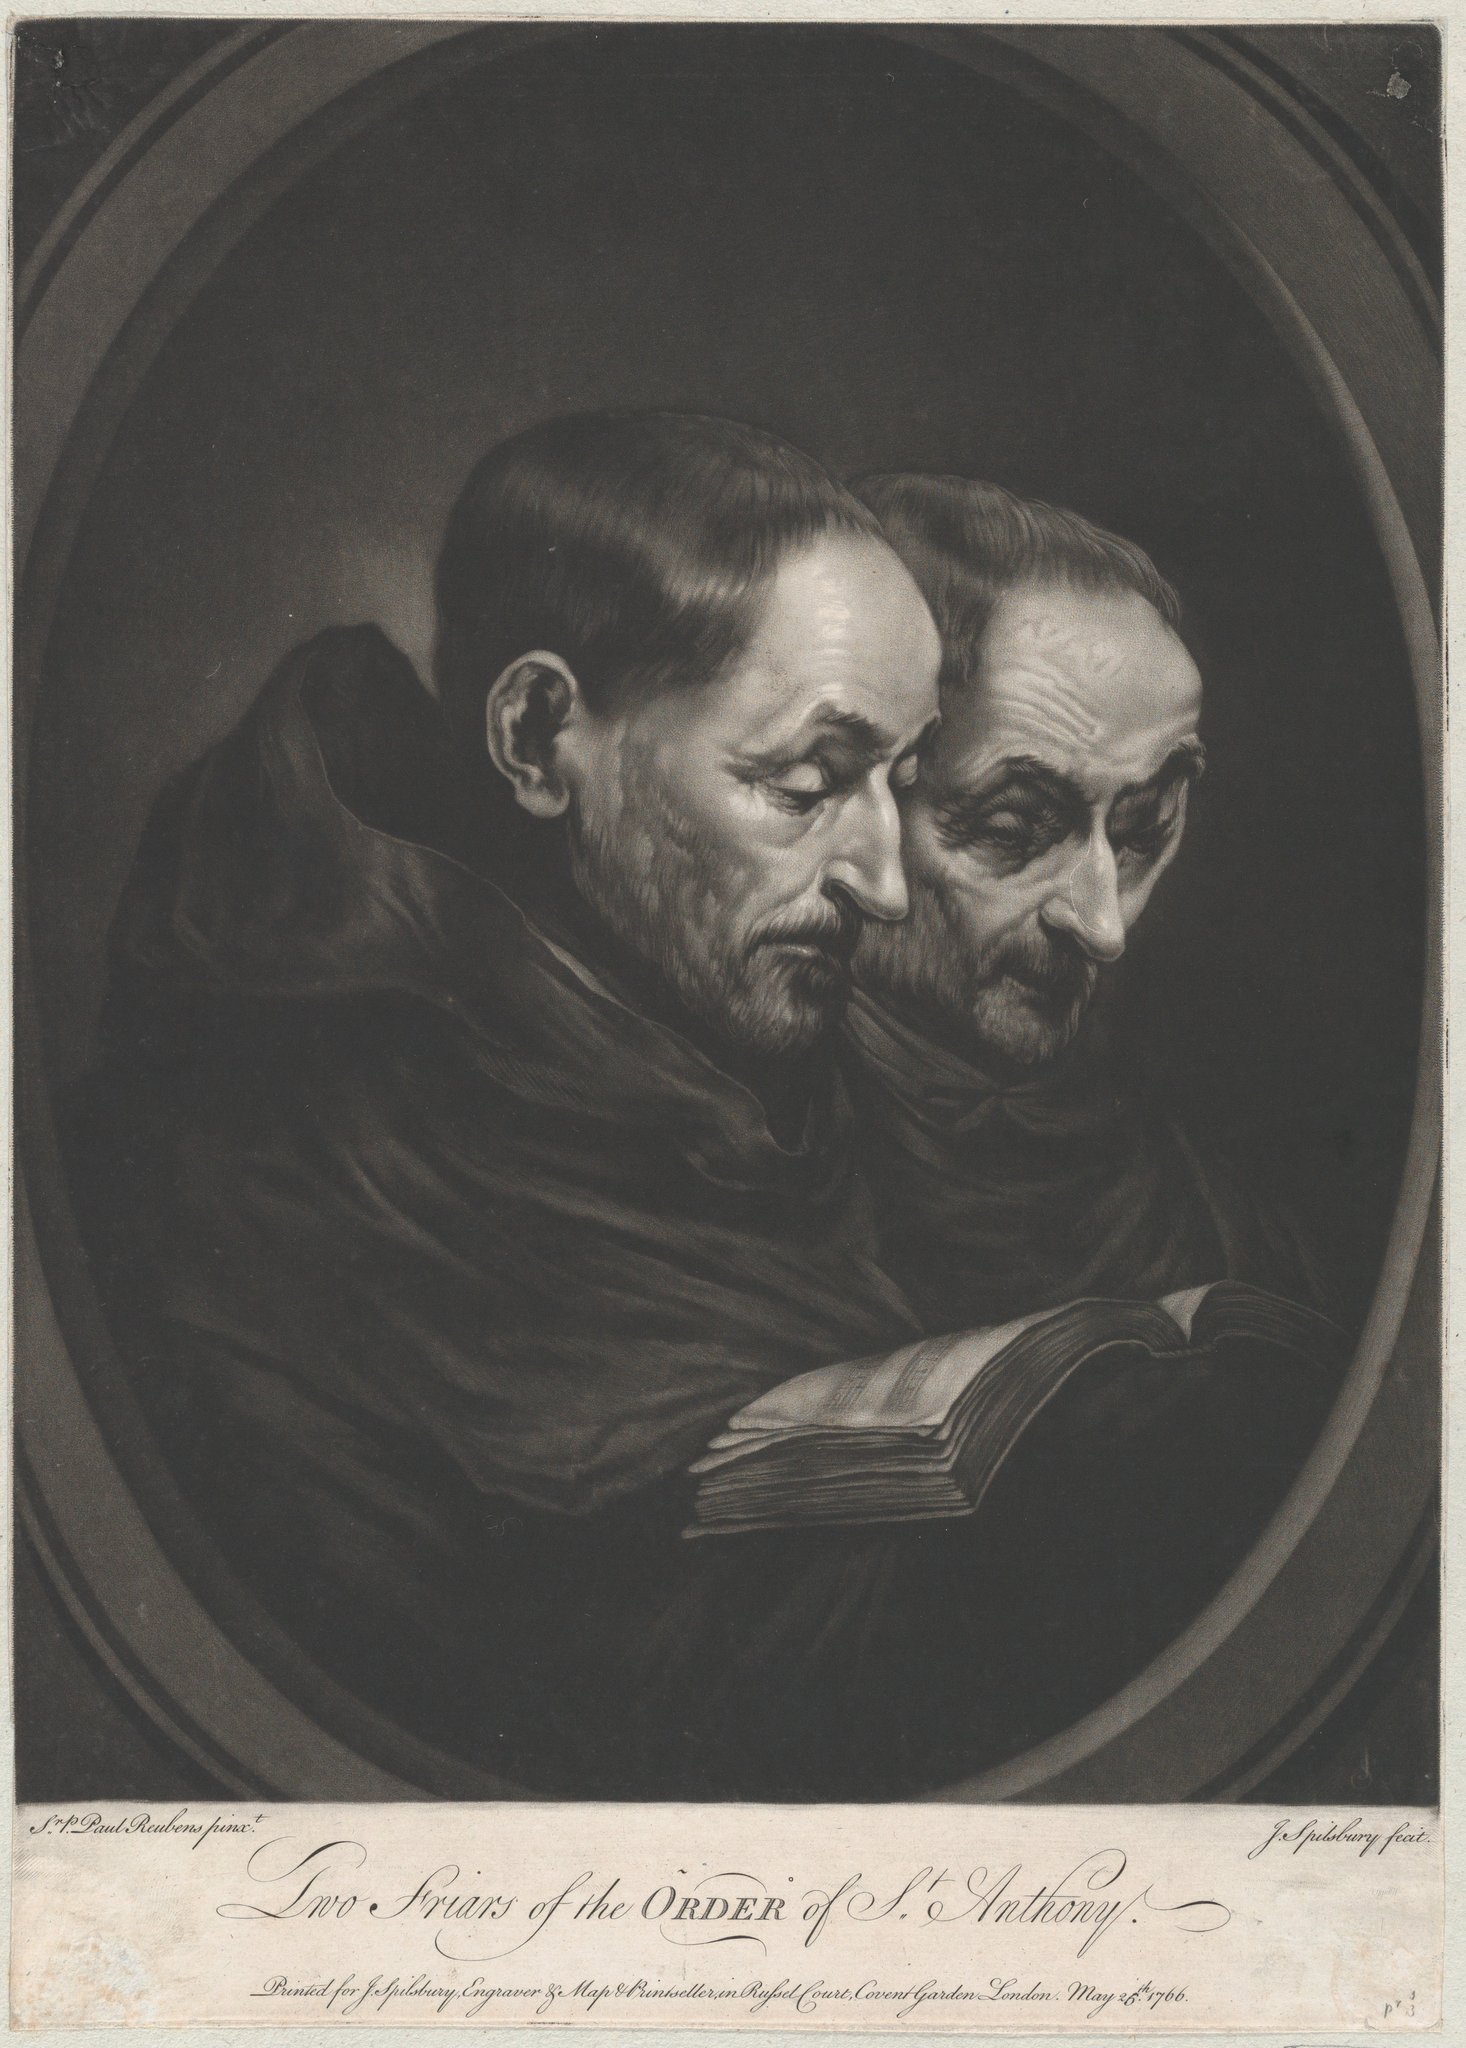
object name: print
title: Two Friars of the Order of Saint Anthony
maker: jonathan spilsbury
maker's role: print maker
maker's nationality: british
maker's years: 1737-1812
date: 1766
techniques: mezzotint